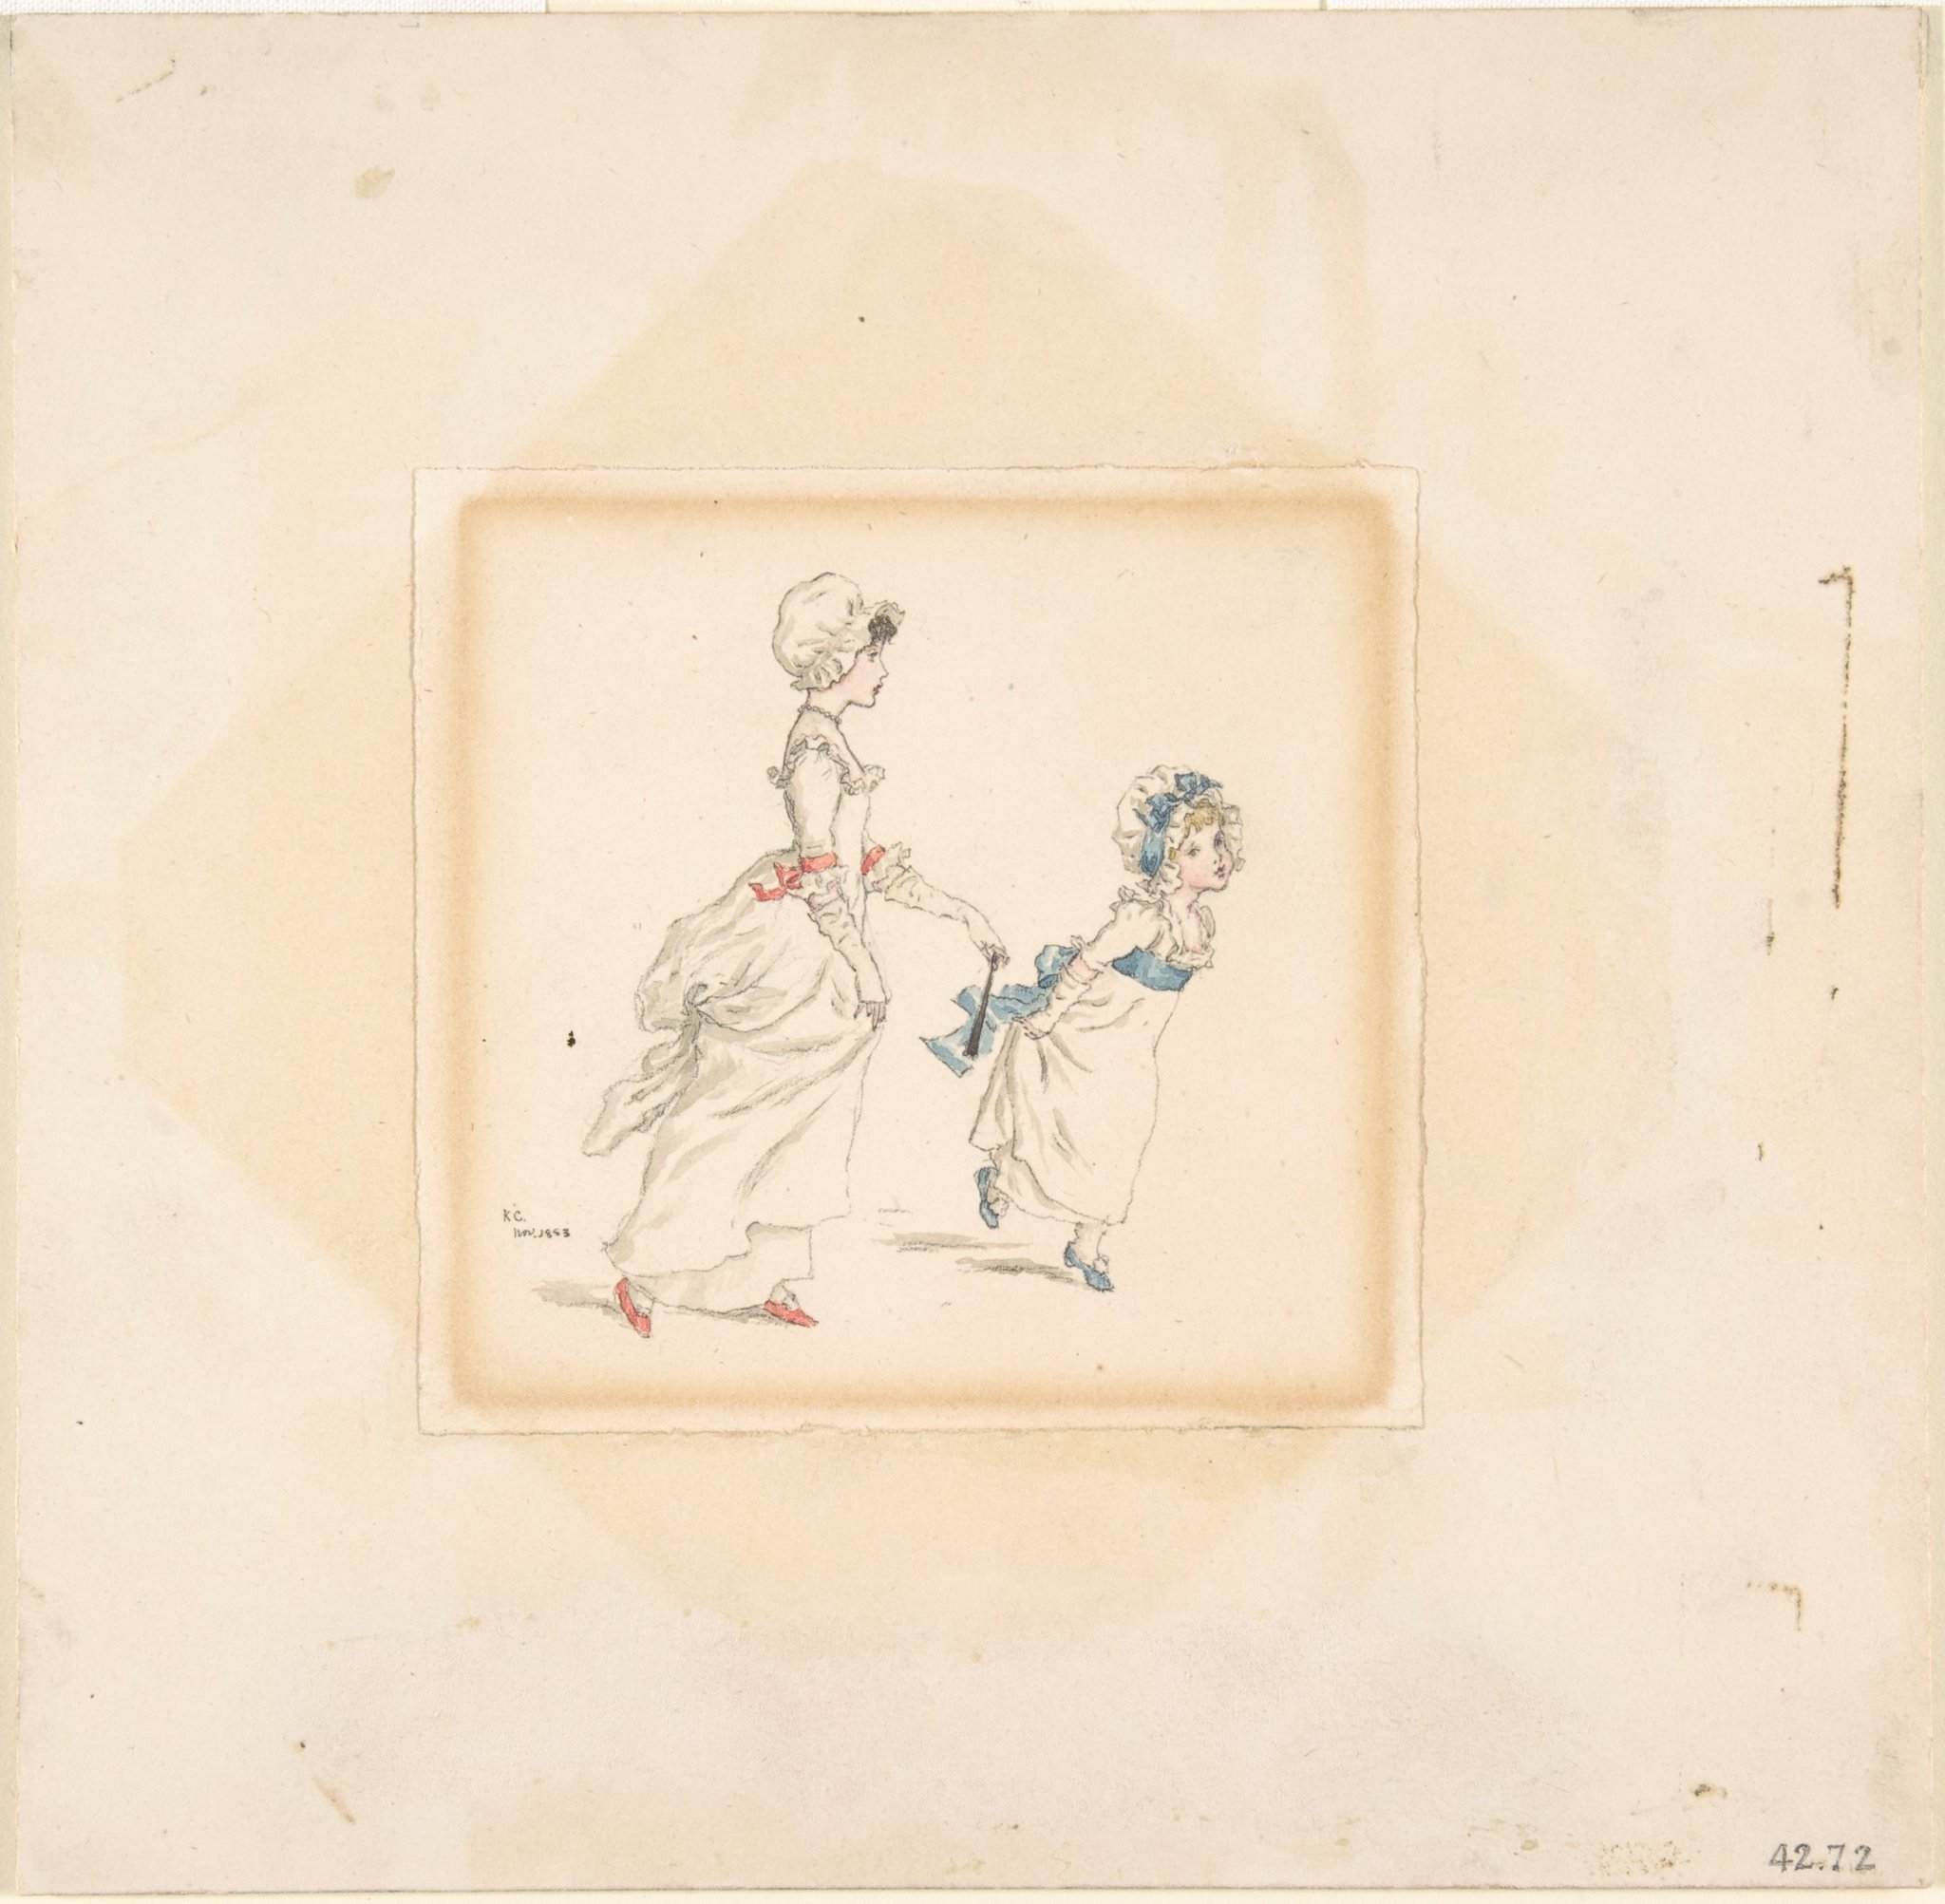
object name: drawing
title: Woman and Child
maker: kate greenaway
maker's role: artist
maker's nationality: british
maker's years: 1846-1901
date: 1883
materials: graphite, watercolor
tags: girls,women